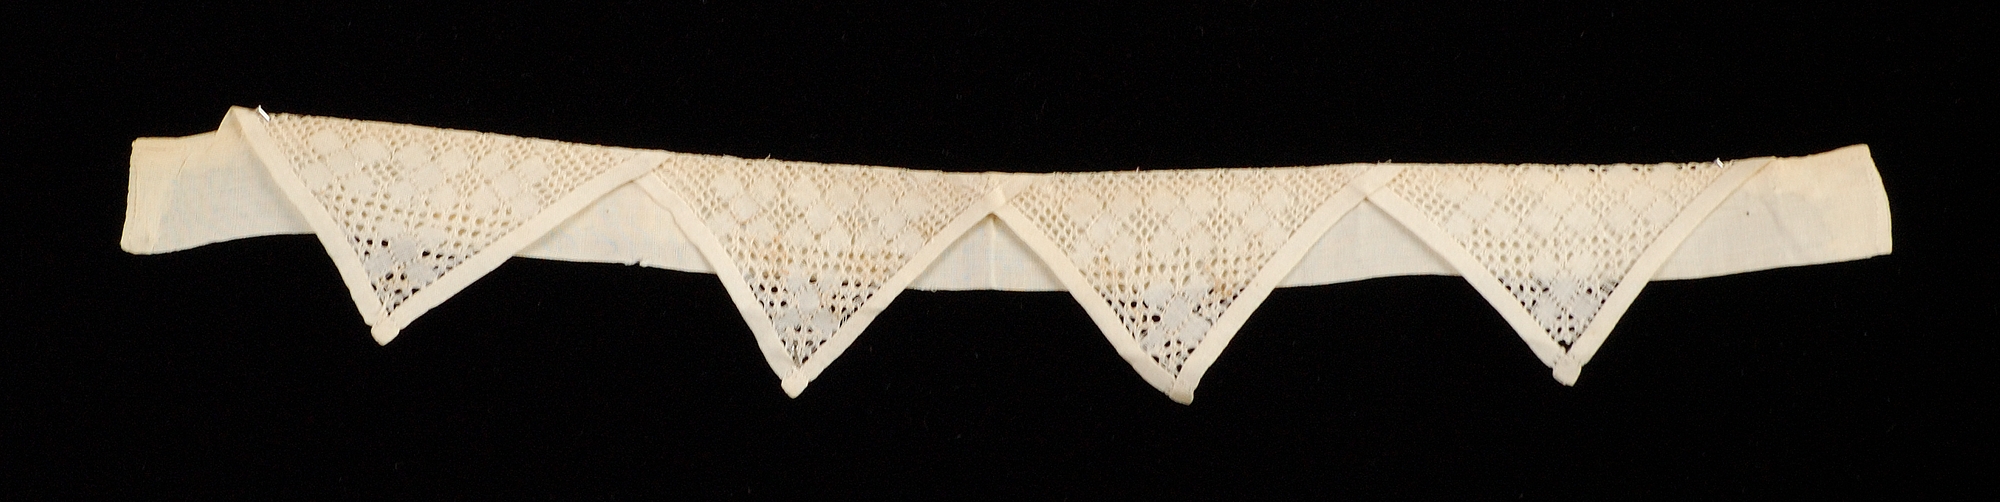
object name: collar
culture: american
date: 1895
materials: linen